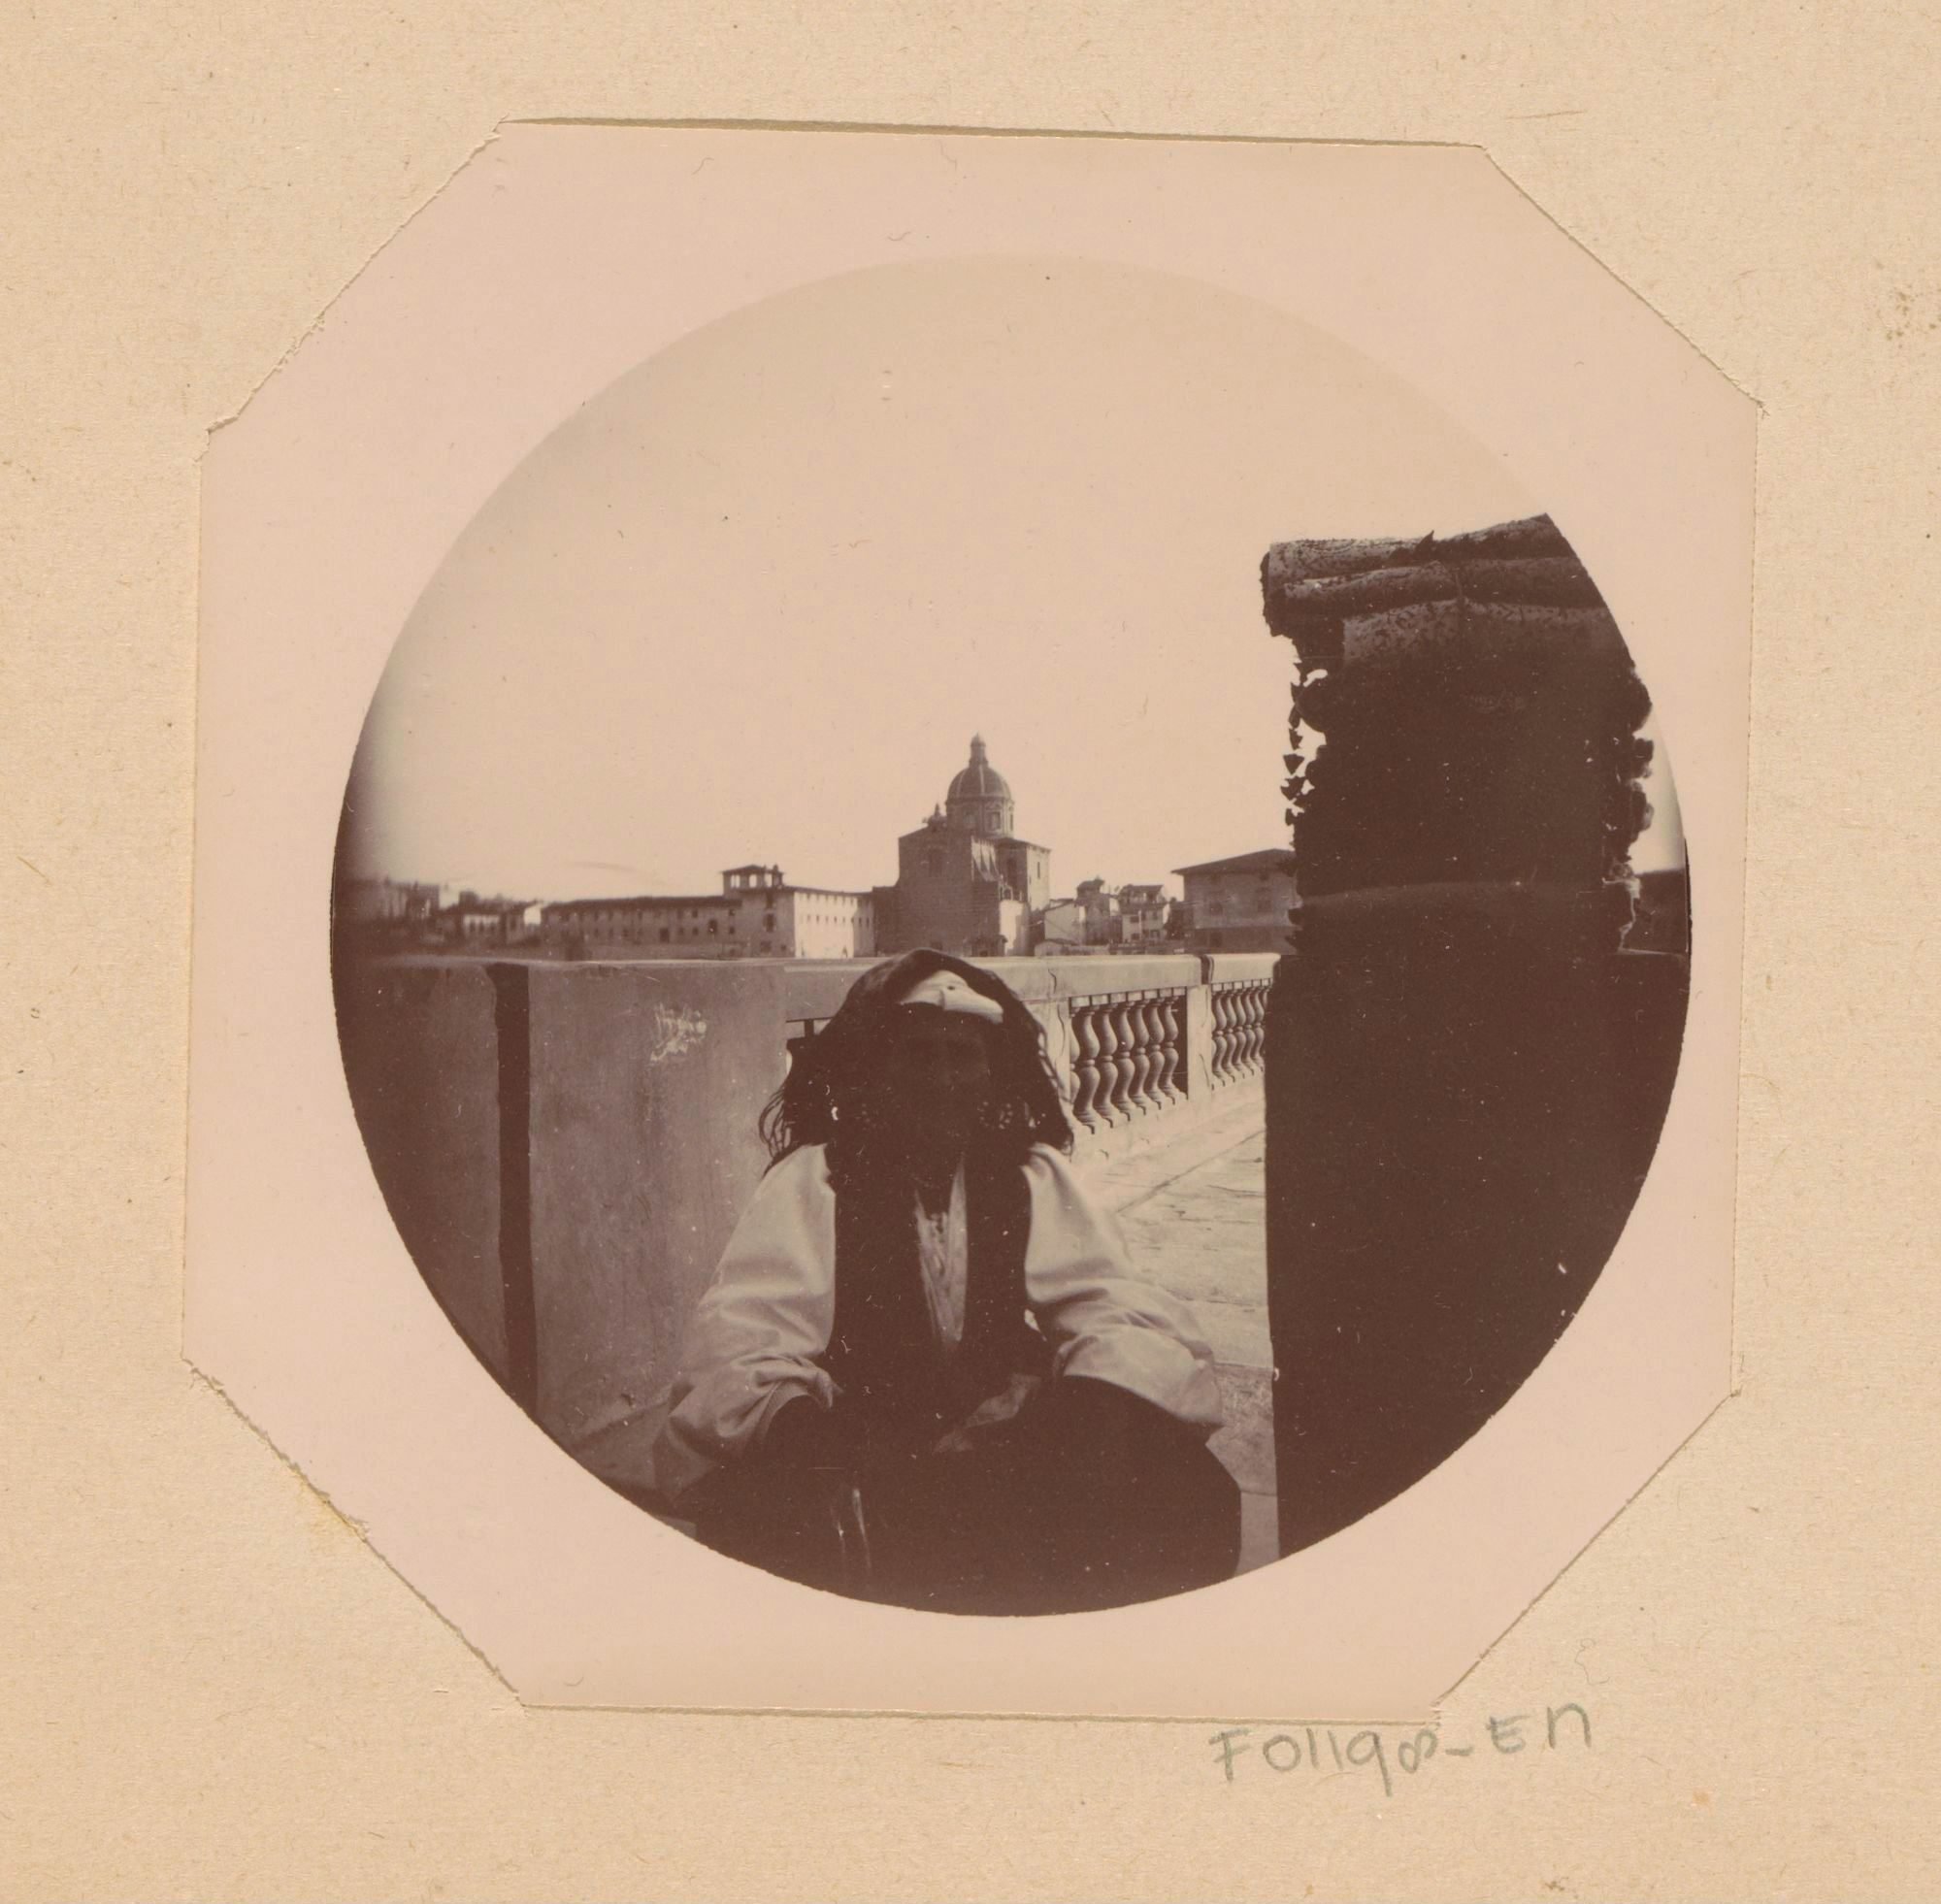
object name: photograph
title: Florence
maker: johanna margaretha piek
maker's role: fotograaf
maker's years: 1870-1947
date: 1889-1893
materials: paper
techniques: gelatin silver print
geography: florence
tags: merchant, salesman - bb - women engaged in trade and commerce